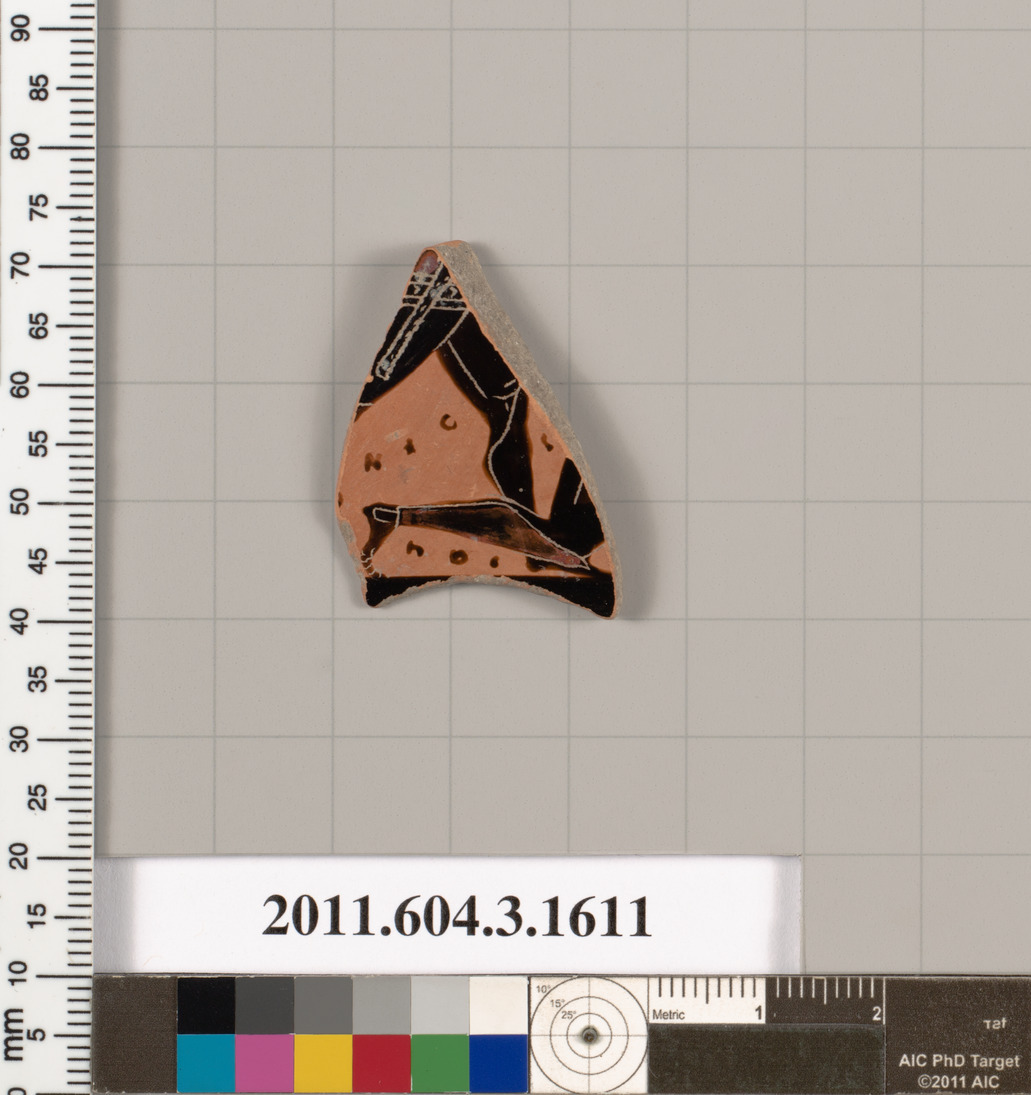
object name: kylix fragment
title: Terracotta fragment of a kylix: Band cup (drinking cup)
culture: greek, attic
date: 560-550 BCE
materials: terracotta